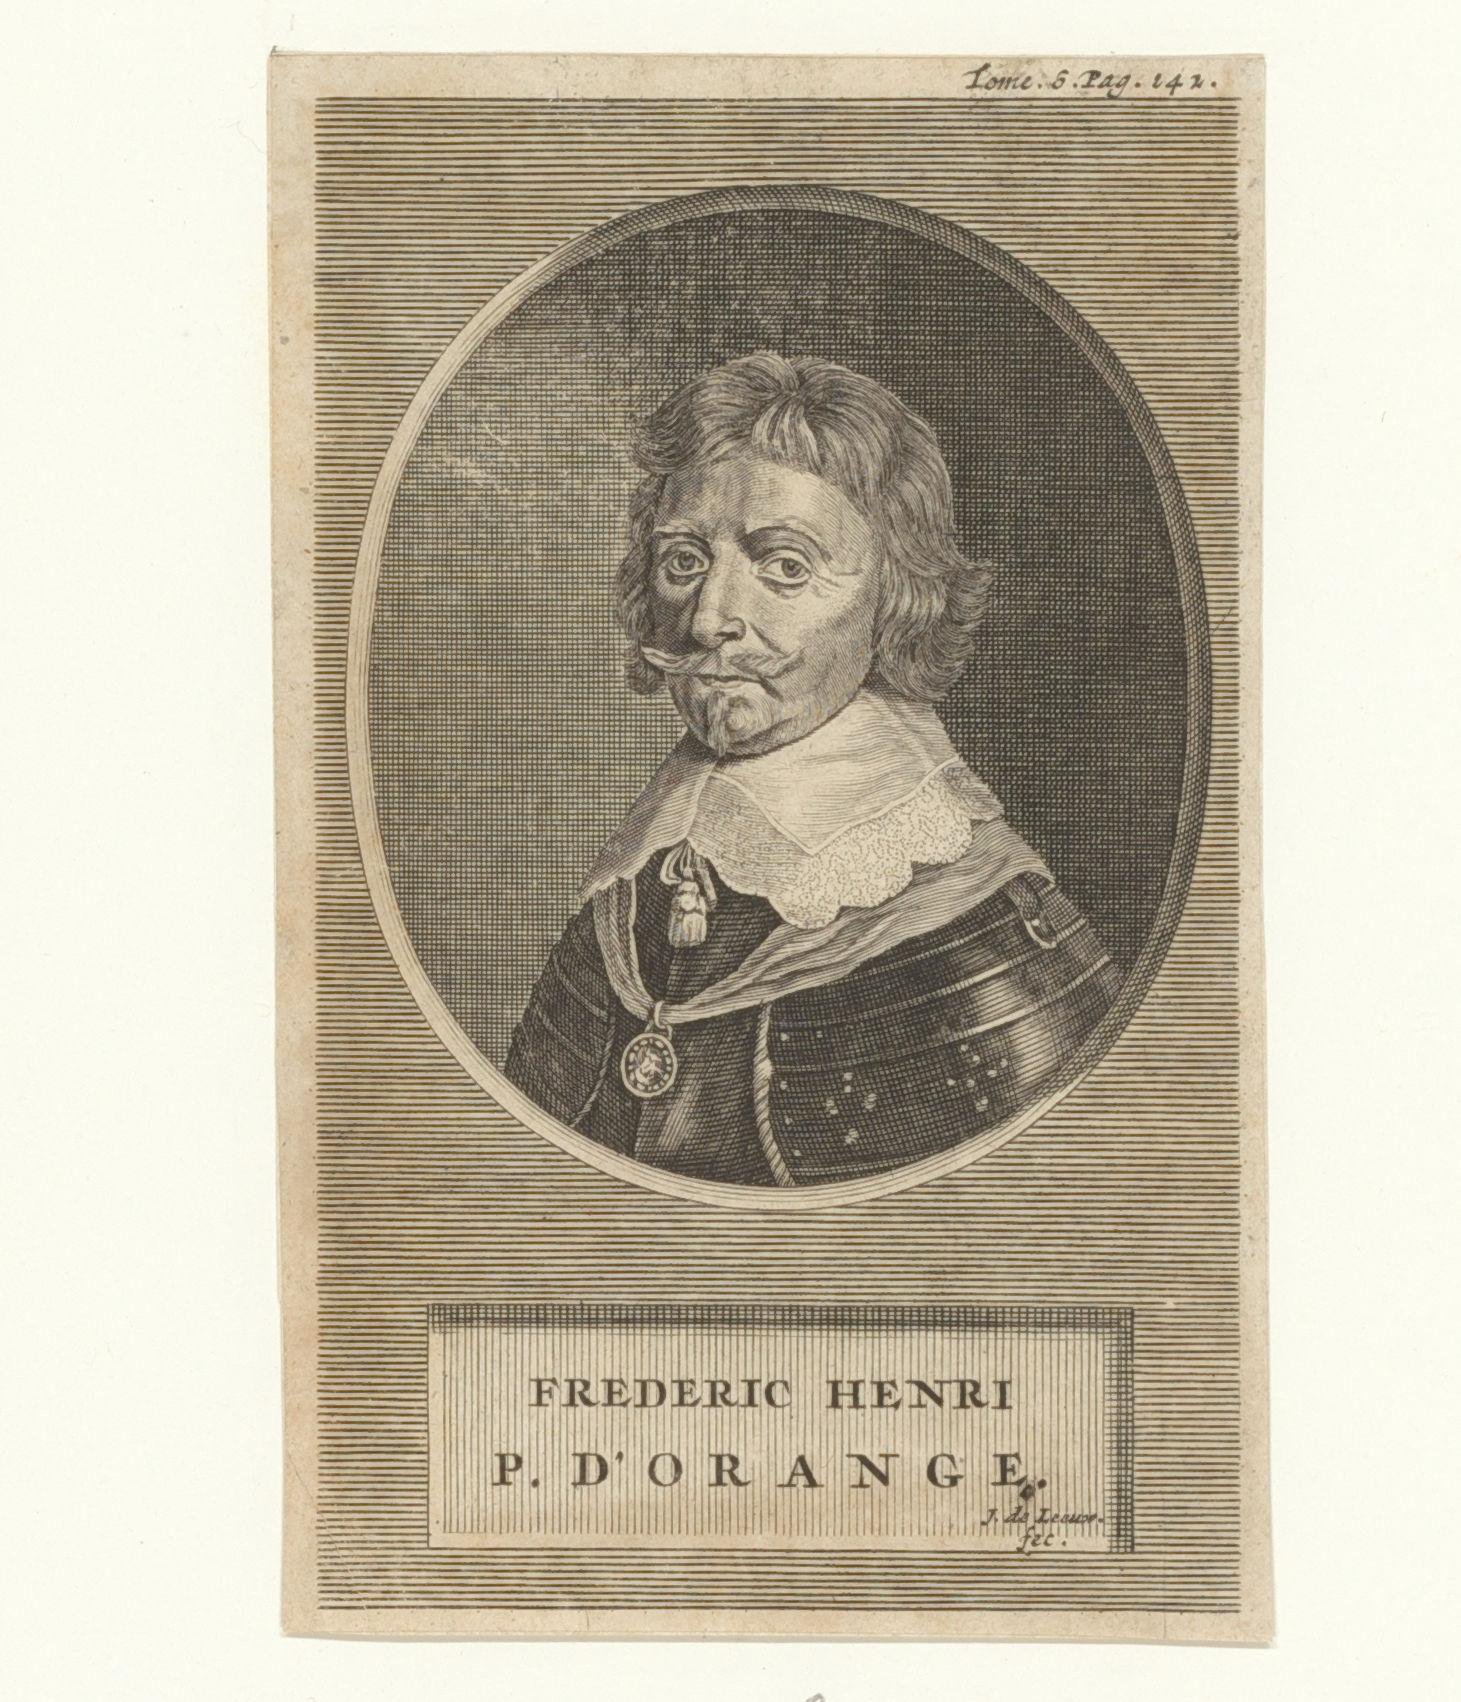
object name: print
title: Frederic Henri P. d'Orange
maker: jan de leeuw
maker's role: print maker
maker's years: 1660-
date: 1753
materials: paper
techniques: etching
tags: the hague, frederick henry (prince of orange), historical persons, knighthood order (garter)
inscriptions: stamp, collector's mark: Lugt 1641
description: Rechtsboven genummerd: Tome. 6. Pag. 142. Onderwerpsrubrieken binnen de Atlas Zeden en Gewoonten: Portretten, Portretten van Vorsten uit het huis van Oranje, Regeerende Vorsten, Stadhouders van Holland, Zeeland en West-Friesland.